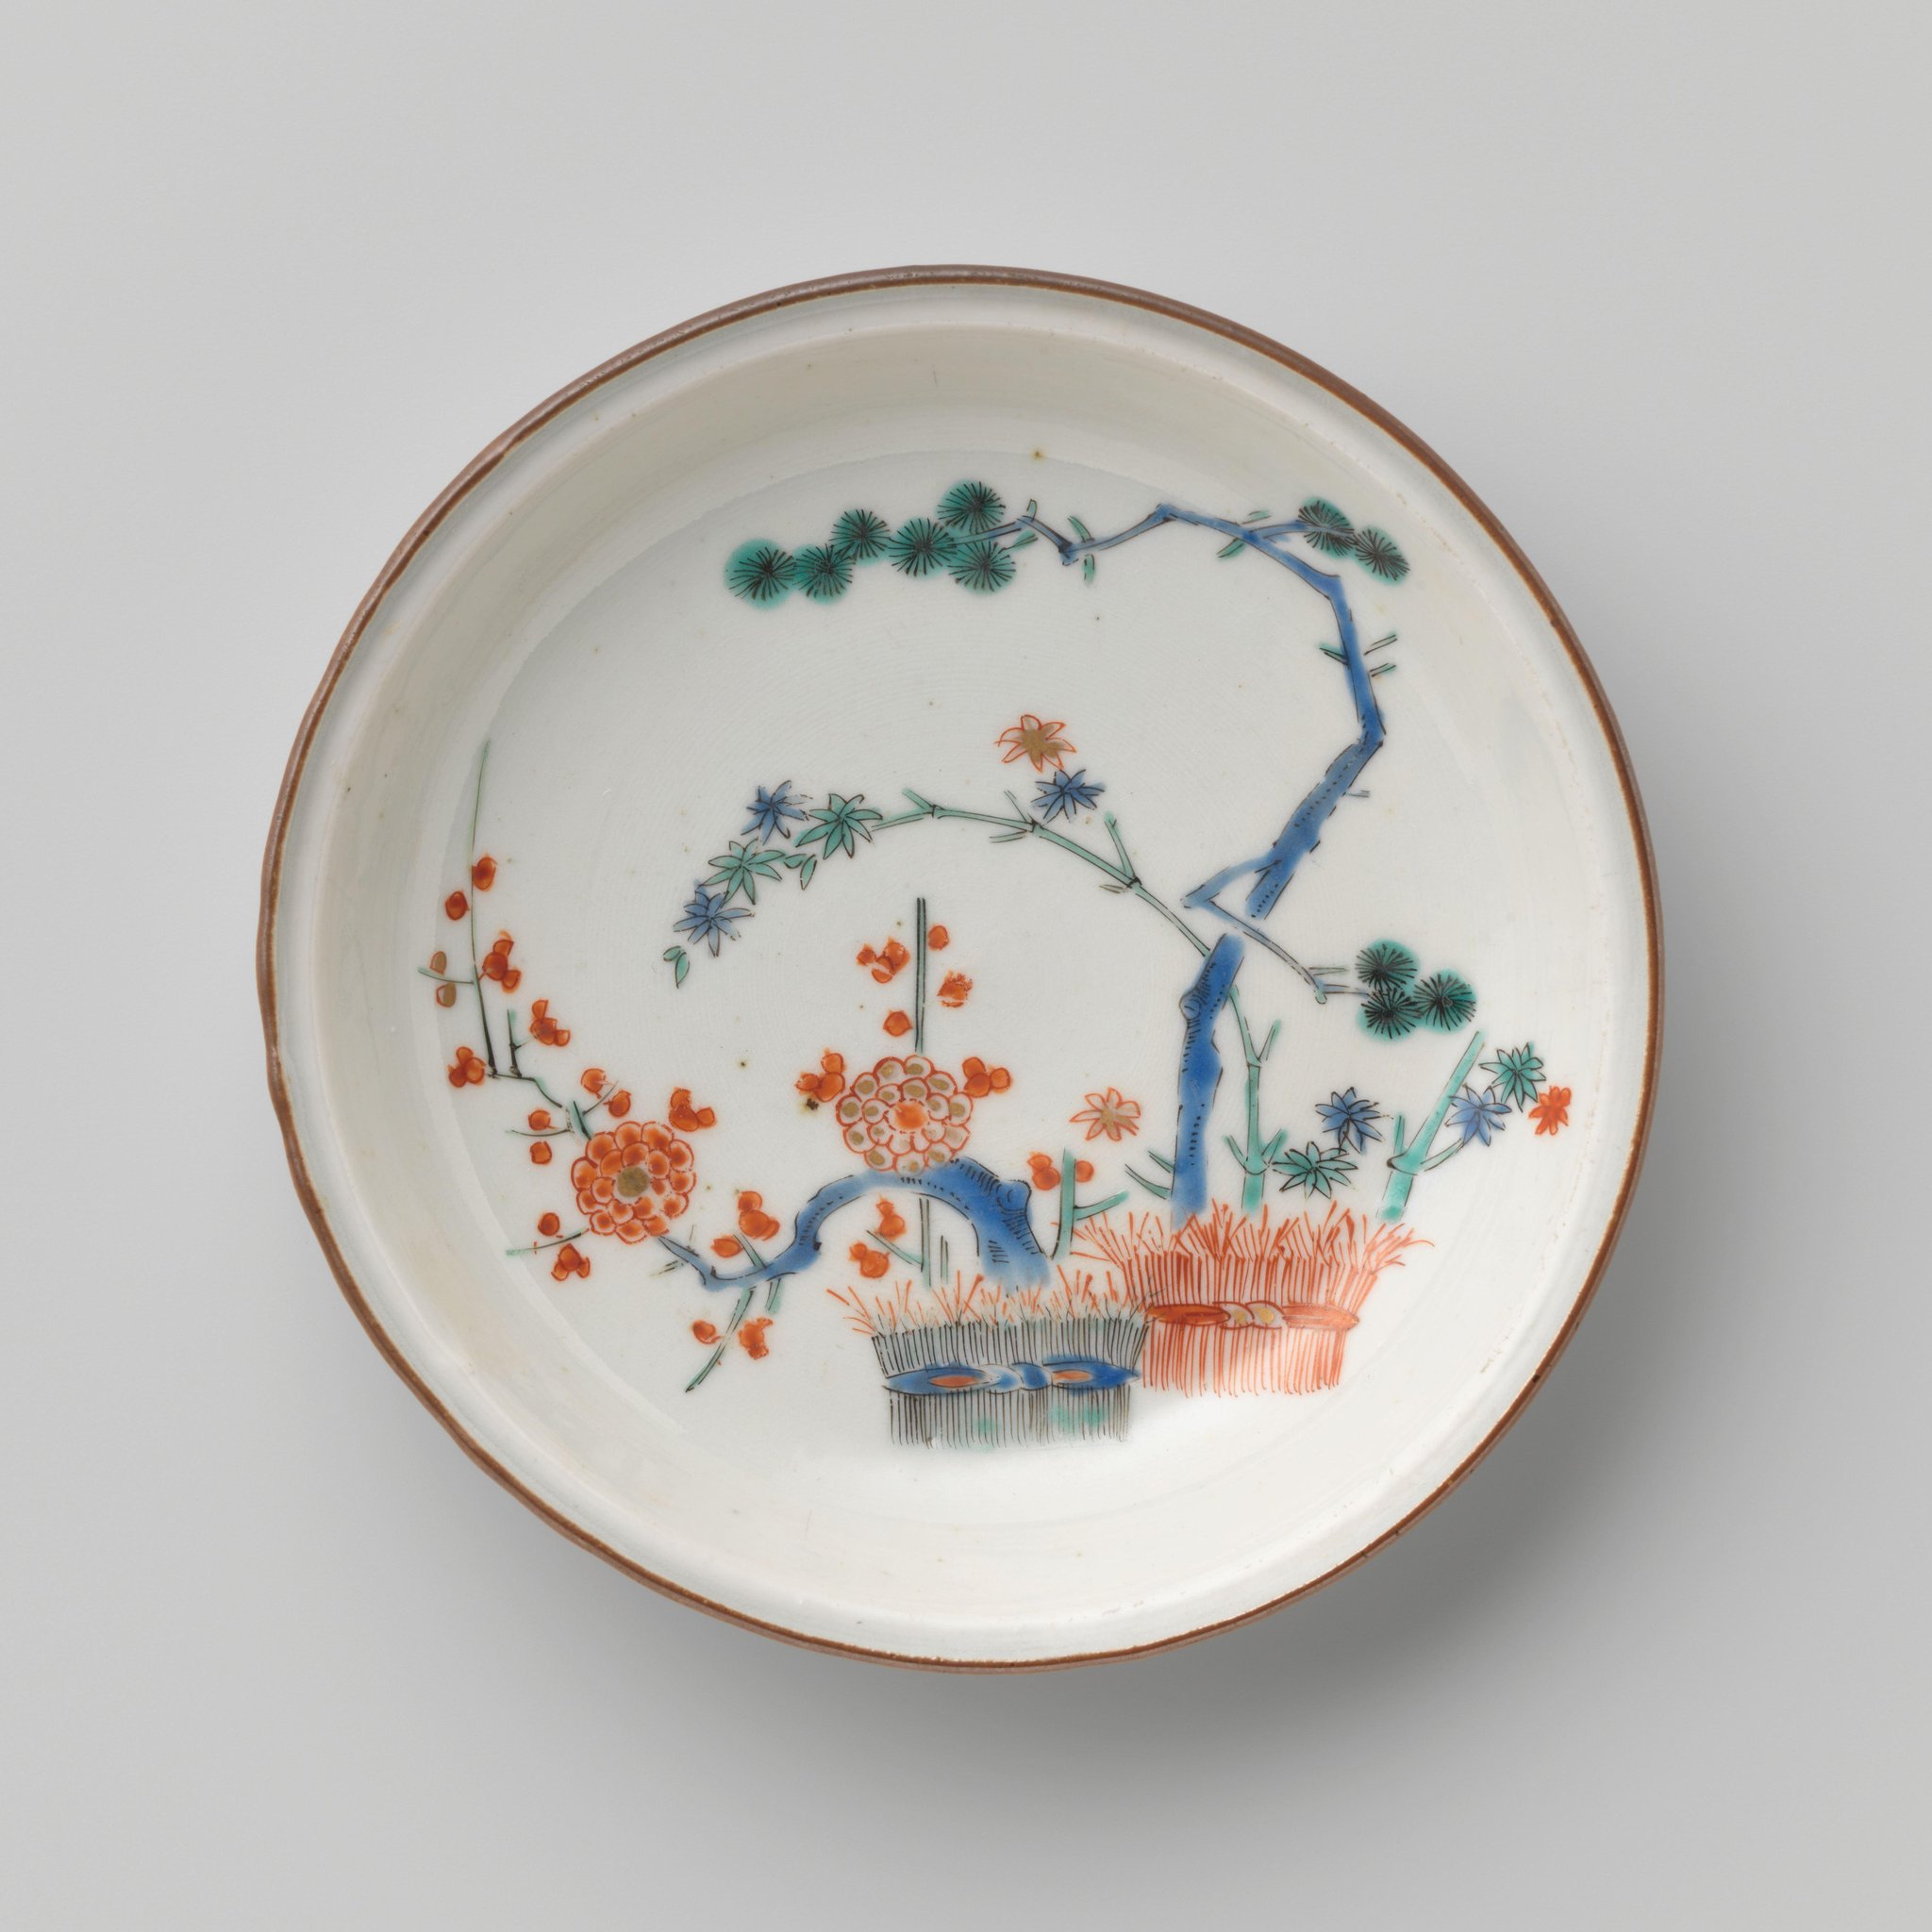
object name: platter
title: Saucer with the 'three friends of winter'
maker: Anonymous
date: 1670-1700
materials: glaze, gold, paint, porcelain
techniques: firing, gilding, turning, vitrification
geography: arita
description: Schotel van porselein, beschilderd op het glazuur in blauw, rood, groen, zwart en goud met de 'drie vrienden van de winter' (bamboe, prunus, pijnboom), bij twee gebonden heggen. Bruine rand. Kakiemon-stijl.